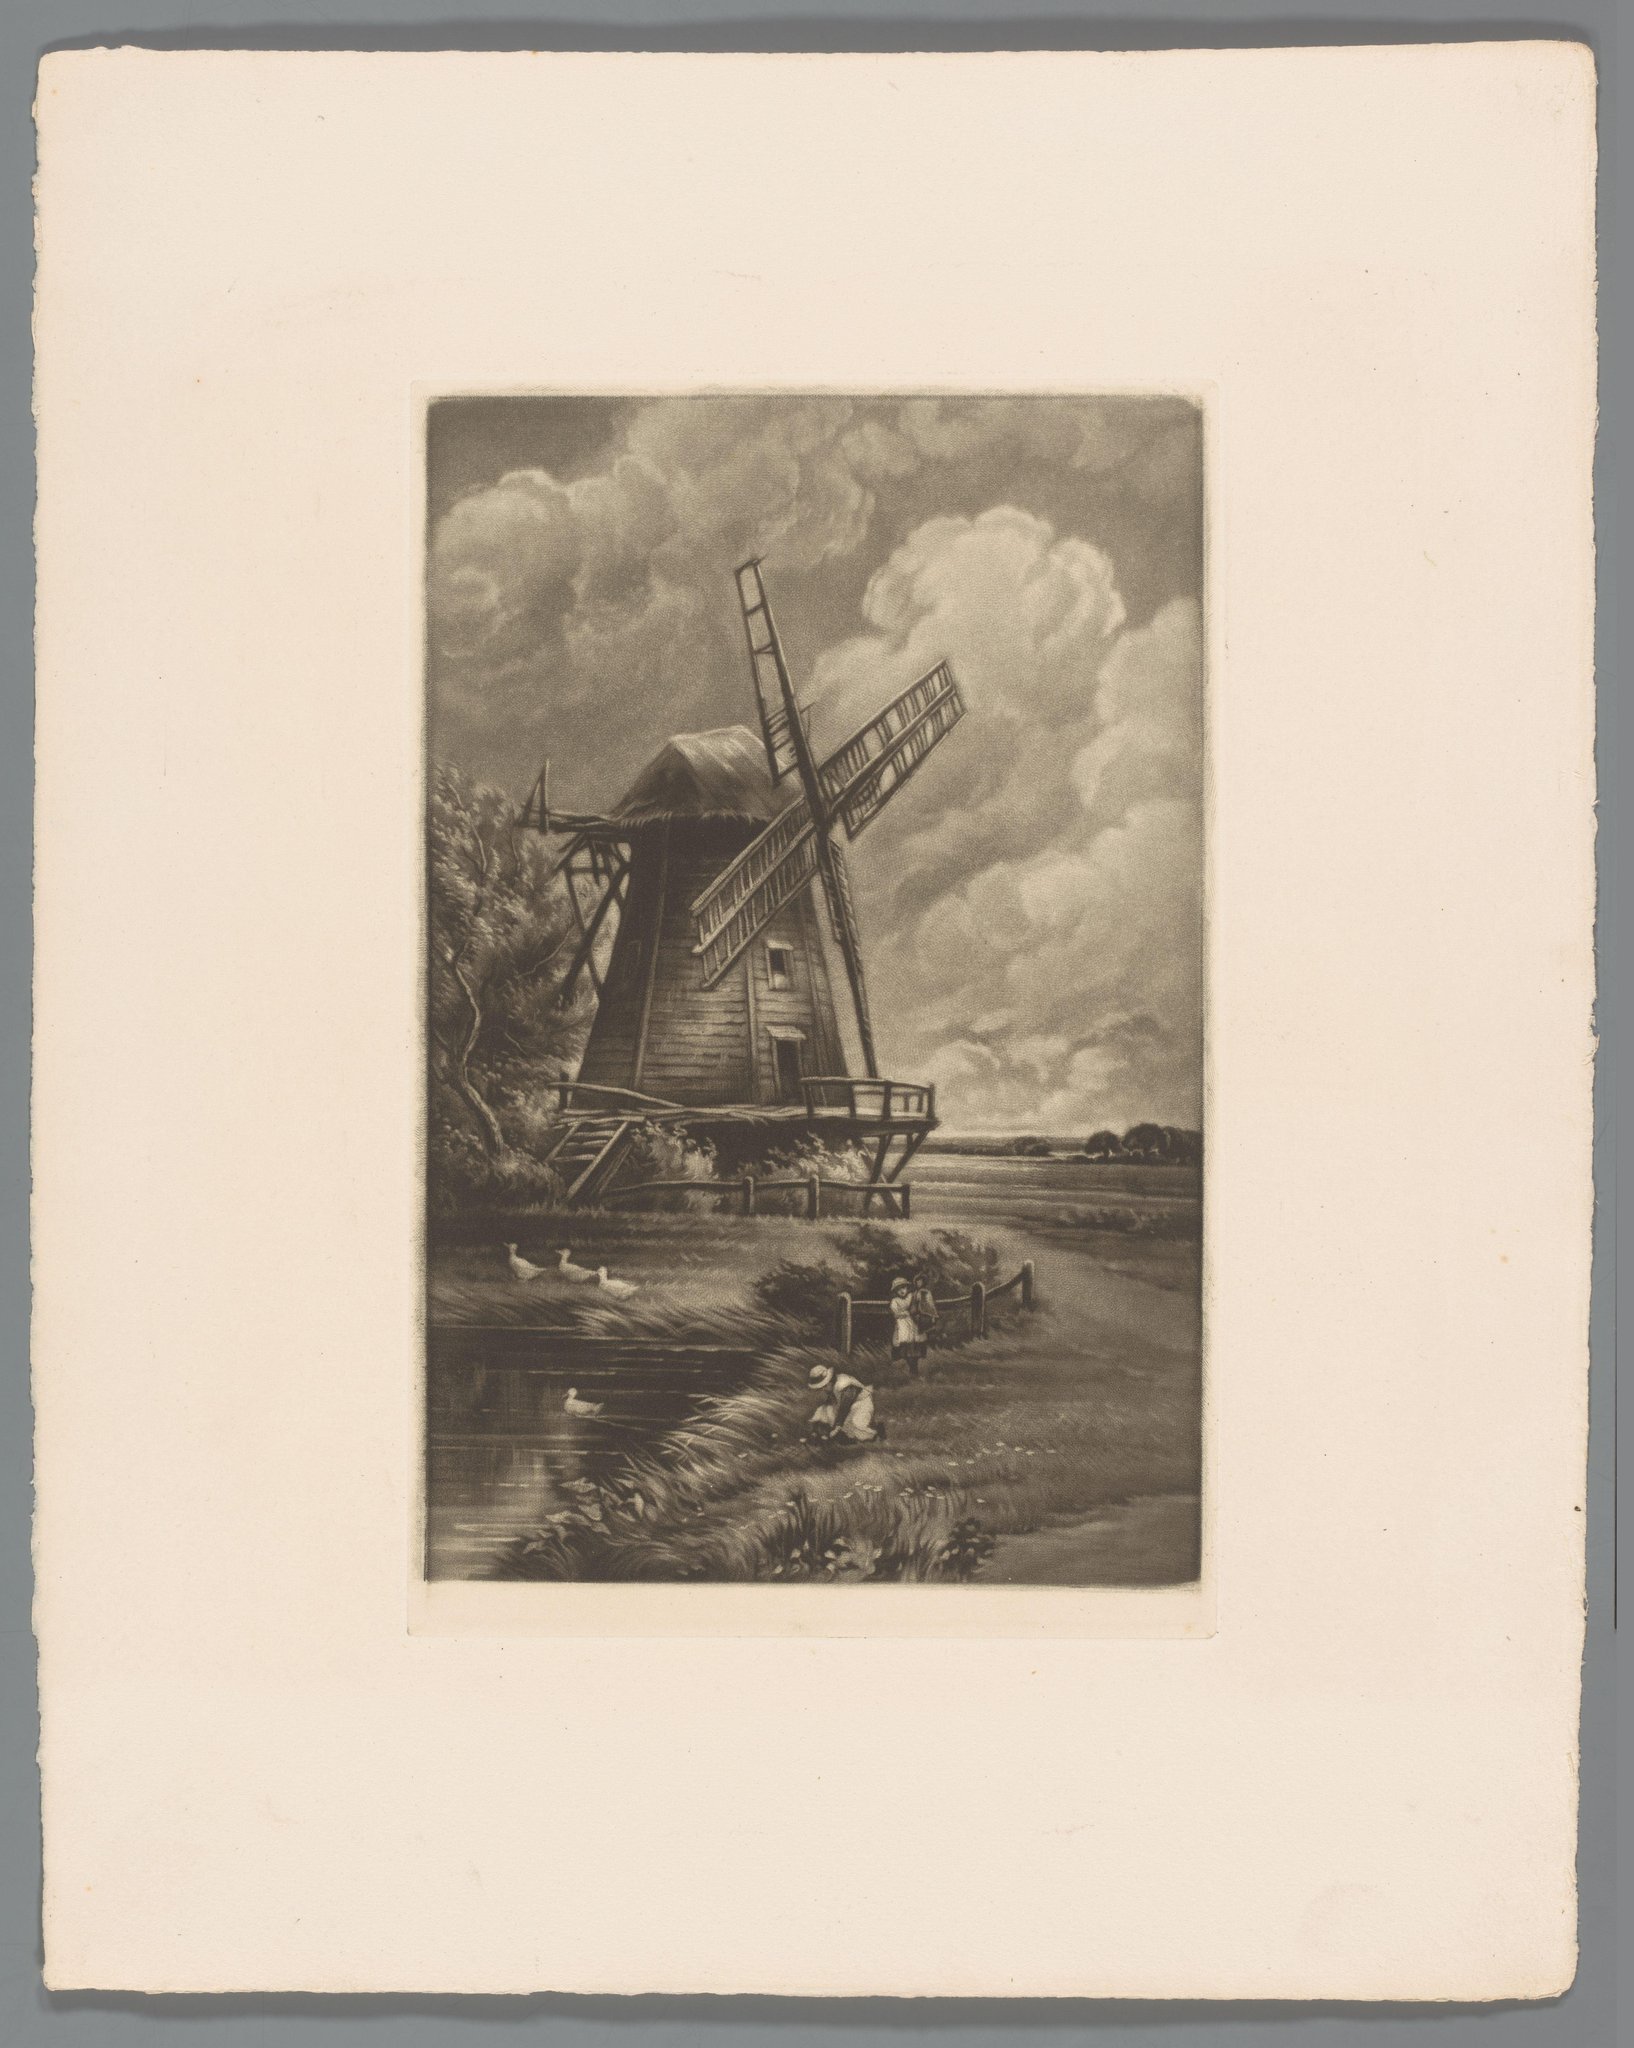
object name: print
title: The Old Mill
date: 1904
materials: paper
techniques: mezzotint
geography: london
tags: windmill in landscape (+ city(-scape) with figures, staffage)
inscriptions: collector's mark: Lugt 2228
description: Prent gebruikt in: The Artist Engraver: A Quarterly Magazine of Original Work (1904).